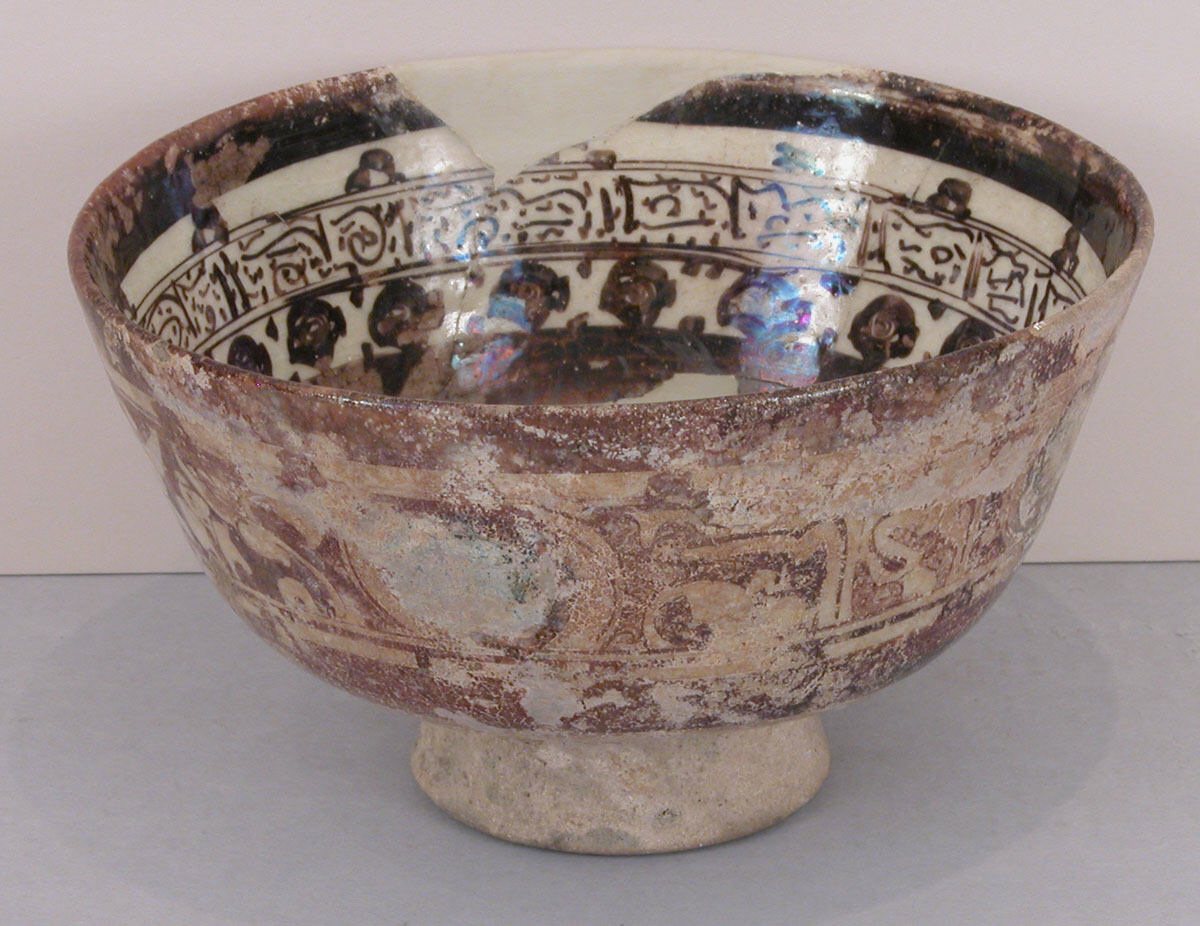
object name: bowl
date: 1101-1200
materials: glaze, stonepaste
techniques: painting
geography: syria